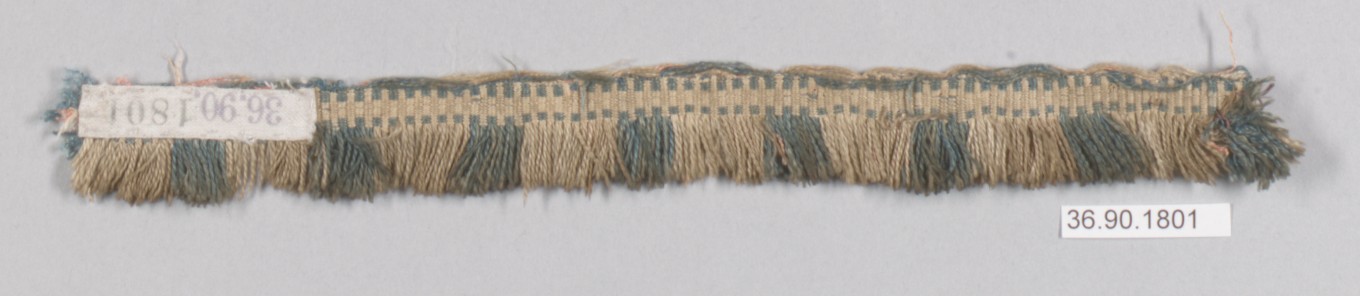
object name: fringe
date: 1867-1900